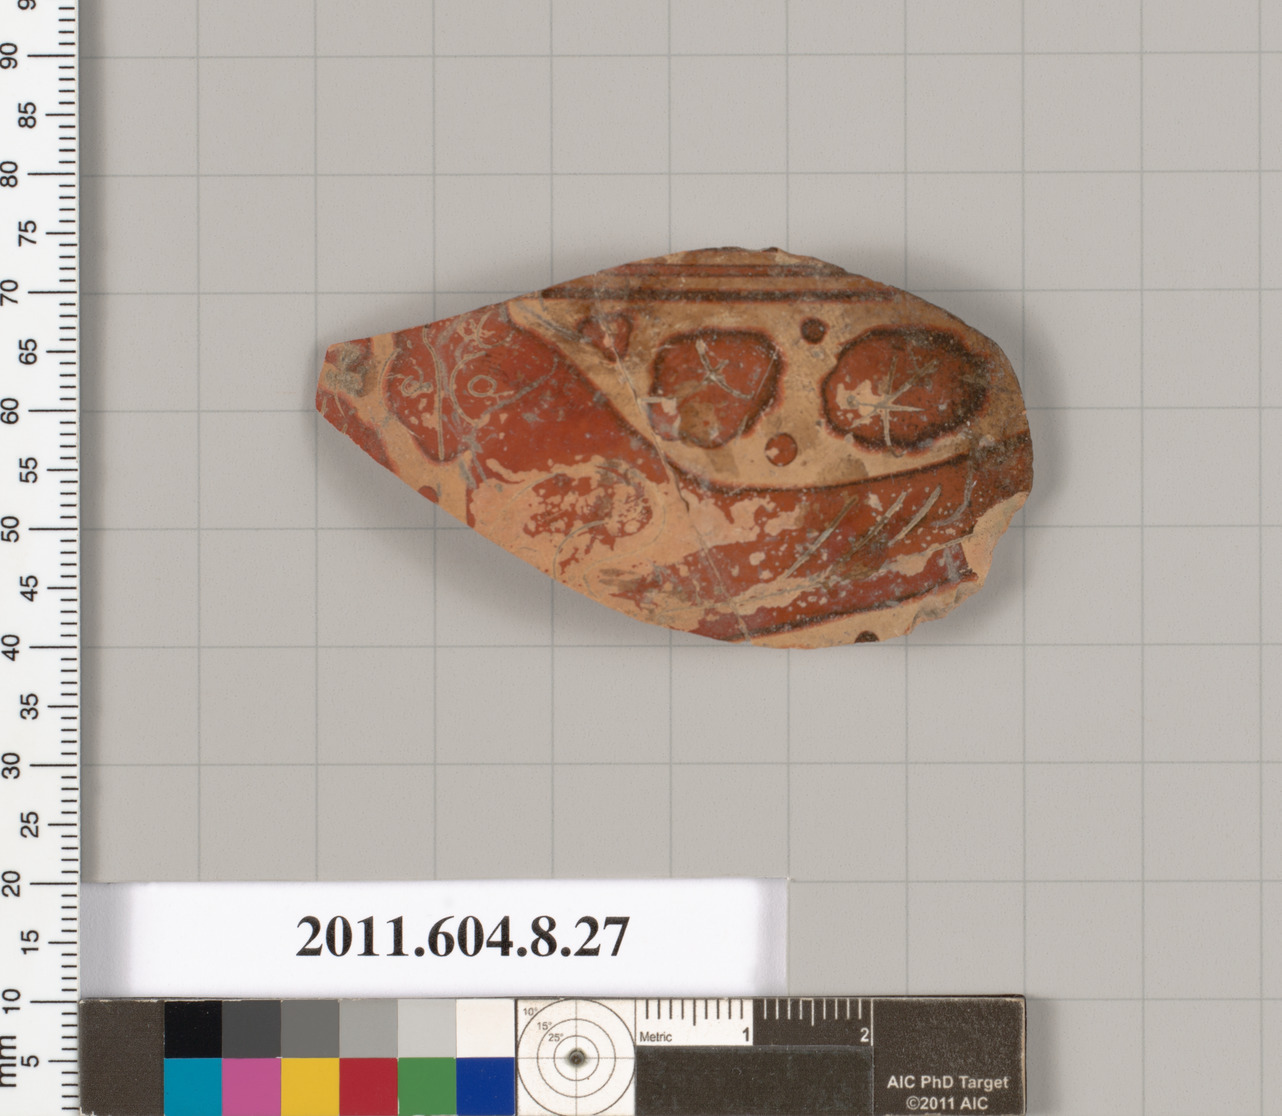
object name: undetermined closed shape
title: Terracotta fragment of a closed shape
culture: etruscan, etrusco-corinthian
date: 600-501 BCE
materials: terracotta